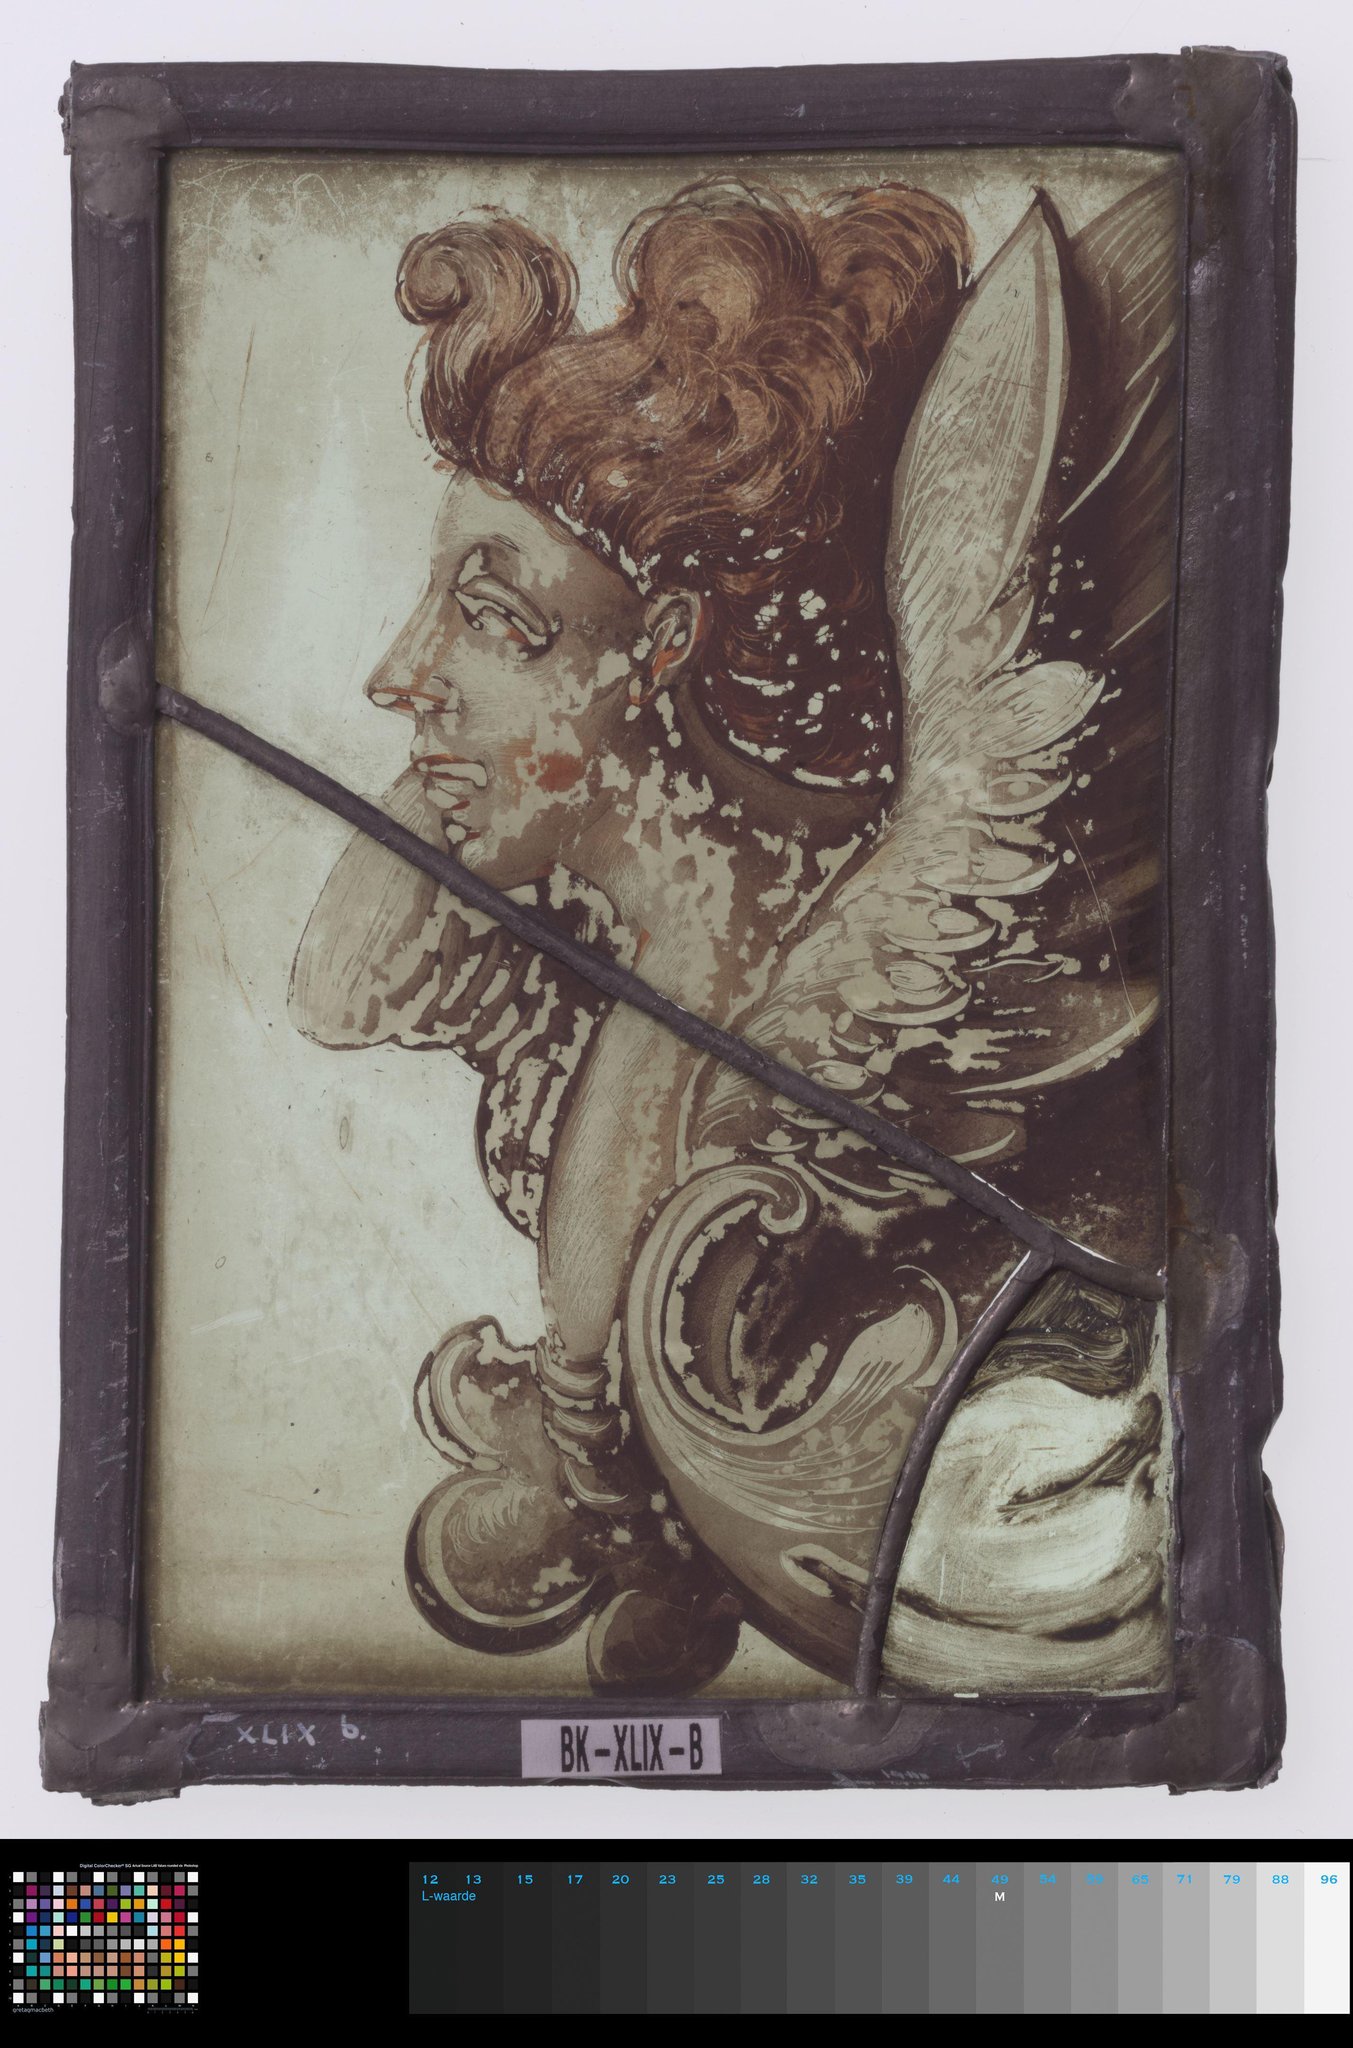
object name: light window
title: Ruit met engelenfiguur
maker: Anonymous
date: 1600-1699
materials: glass, lead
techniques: leading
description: Een fragment van een ruit, voorstellende een engel met bruin haar. Behoort tot groep inv. nrs. BK-XLIX-A t/m G.